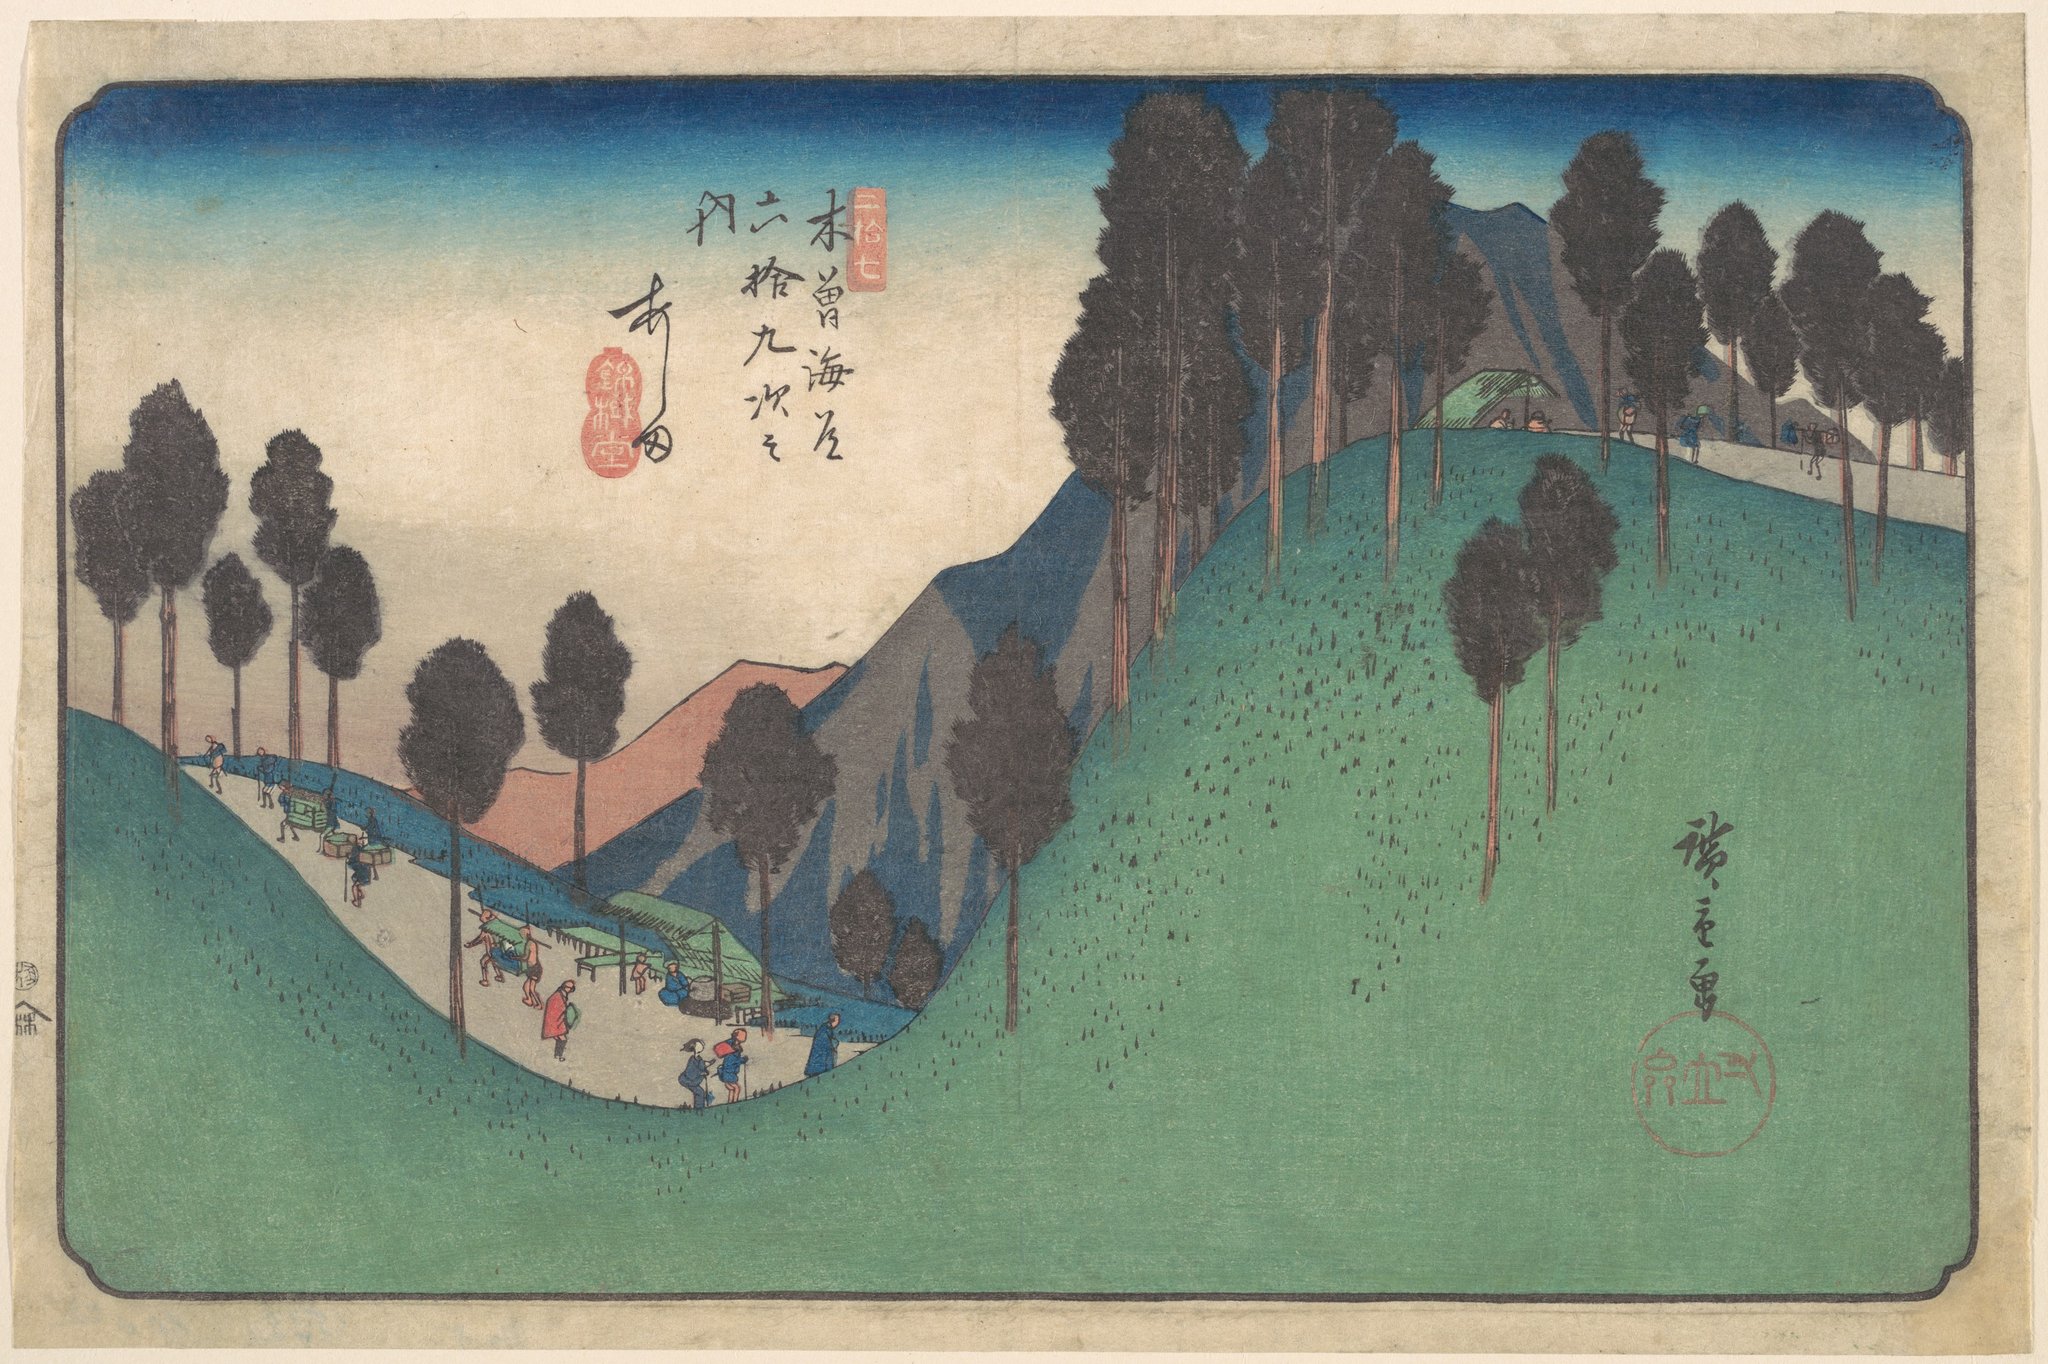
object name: print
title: Ashida Station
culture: japanese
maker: utagawa hiroshige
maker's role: artist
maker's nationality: japanese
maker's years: 1797-1858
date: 1836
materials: ink, paper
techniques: woodblock print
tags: human figures,mountains,trees